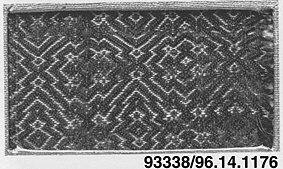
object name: piece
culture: japanese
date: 1701-1900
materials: silk